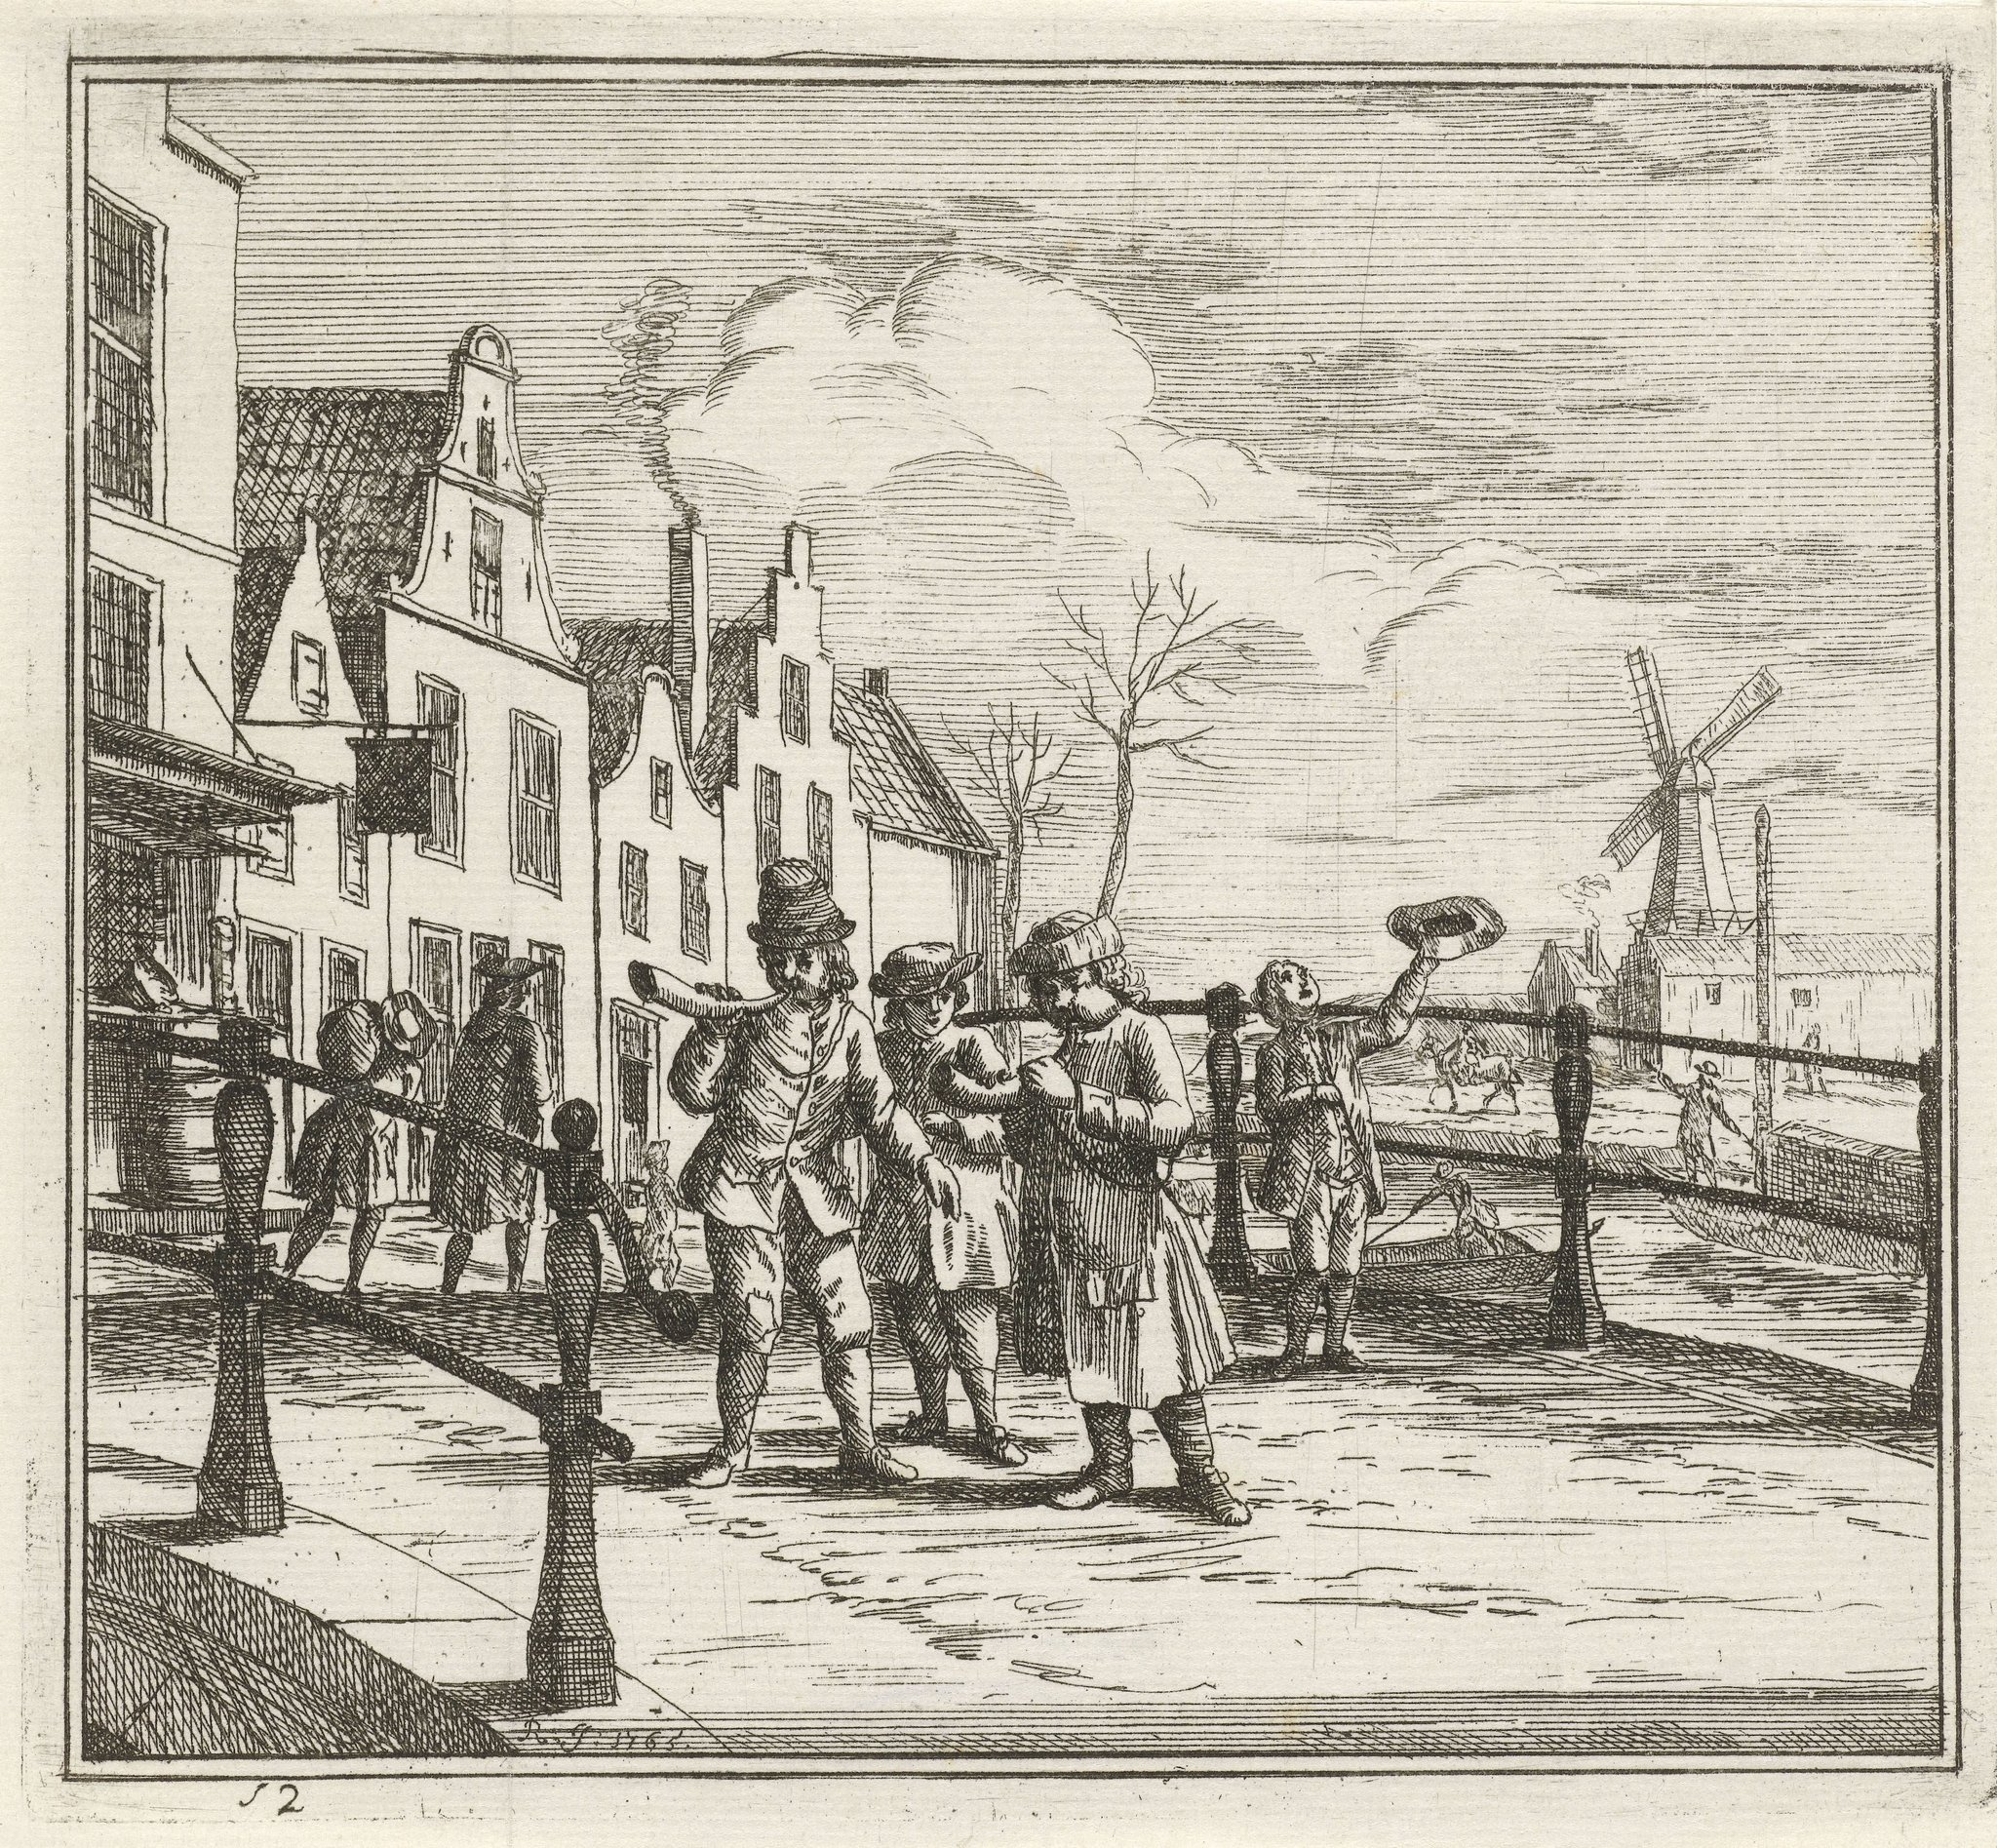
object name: print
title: De Winter.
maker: rienk jelgerhuis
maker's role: draughtsman, print maker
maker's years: 1729-1806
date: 1765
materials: paper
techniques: engraving, etching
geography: leeuwarden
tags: horn, trumpet, cornet, trombone, tuba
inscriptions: collector's mark: Lugt 2228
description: Stadsgezicht met drie mannen op een brug, van wie twee op een hoorn blazen. Achter hen staat een man die zijn hoed in de lucht houdt en omhoog kijkt. Op de achtergrond een molen. Prent uit een serie van dertien met wintertaferelen.